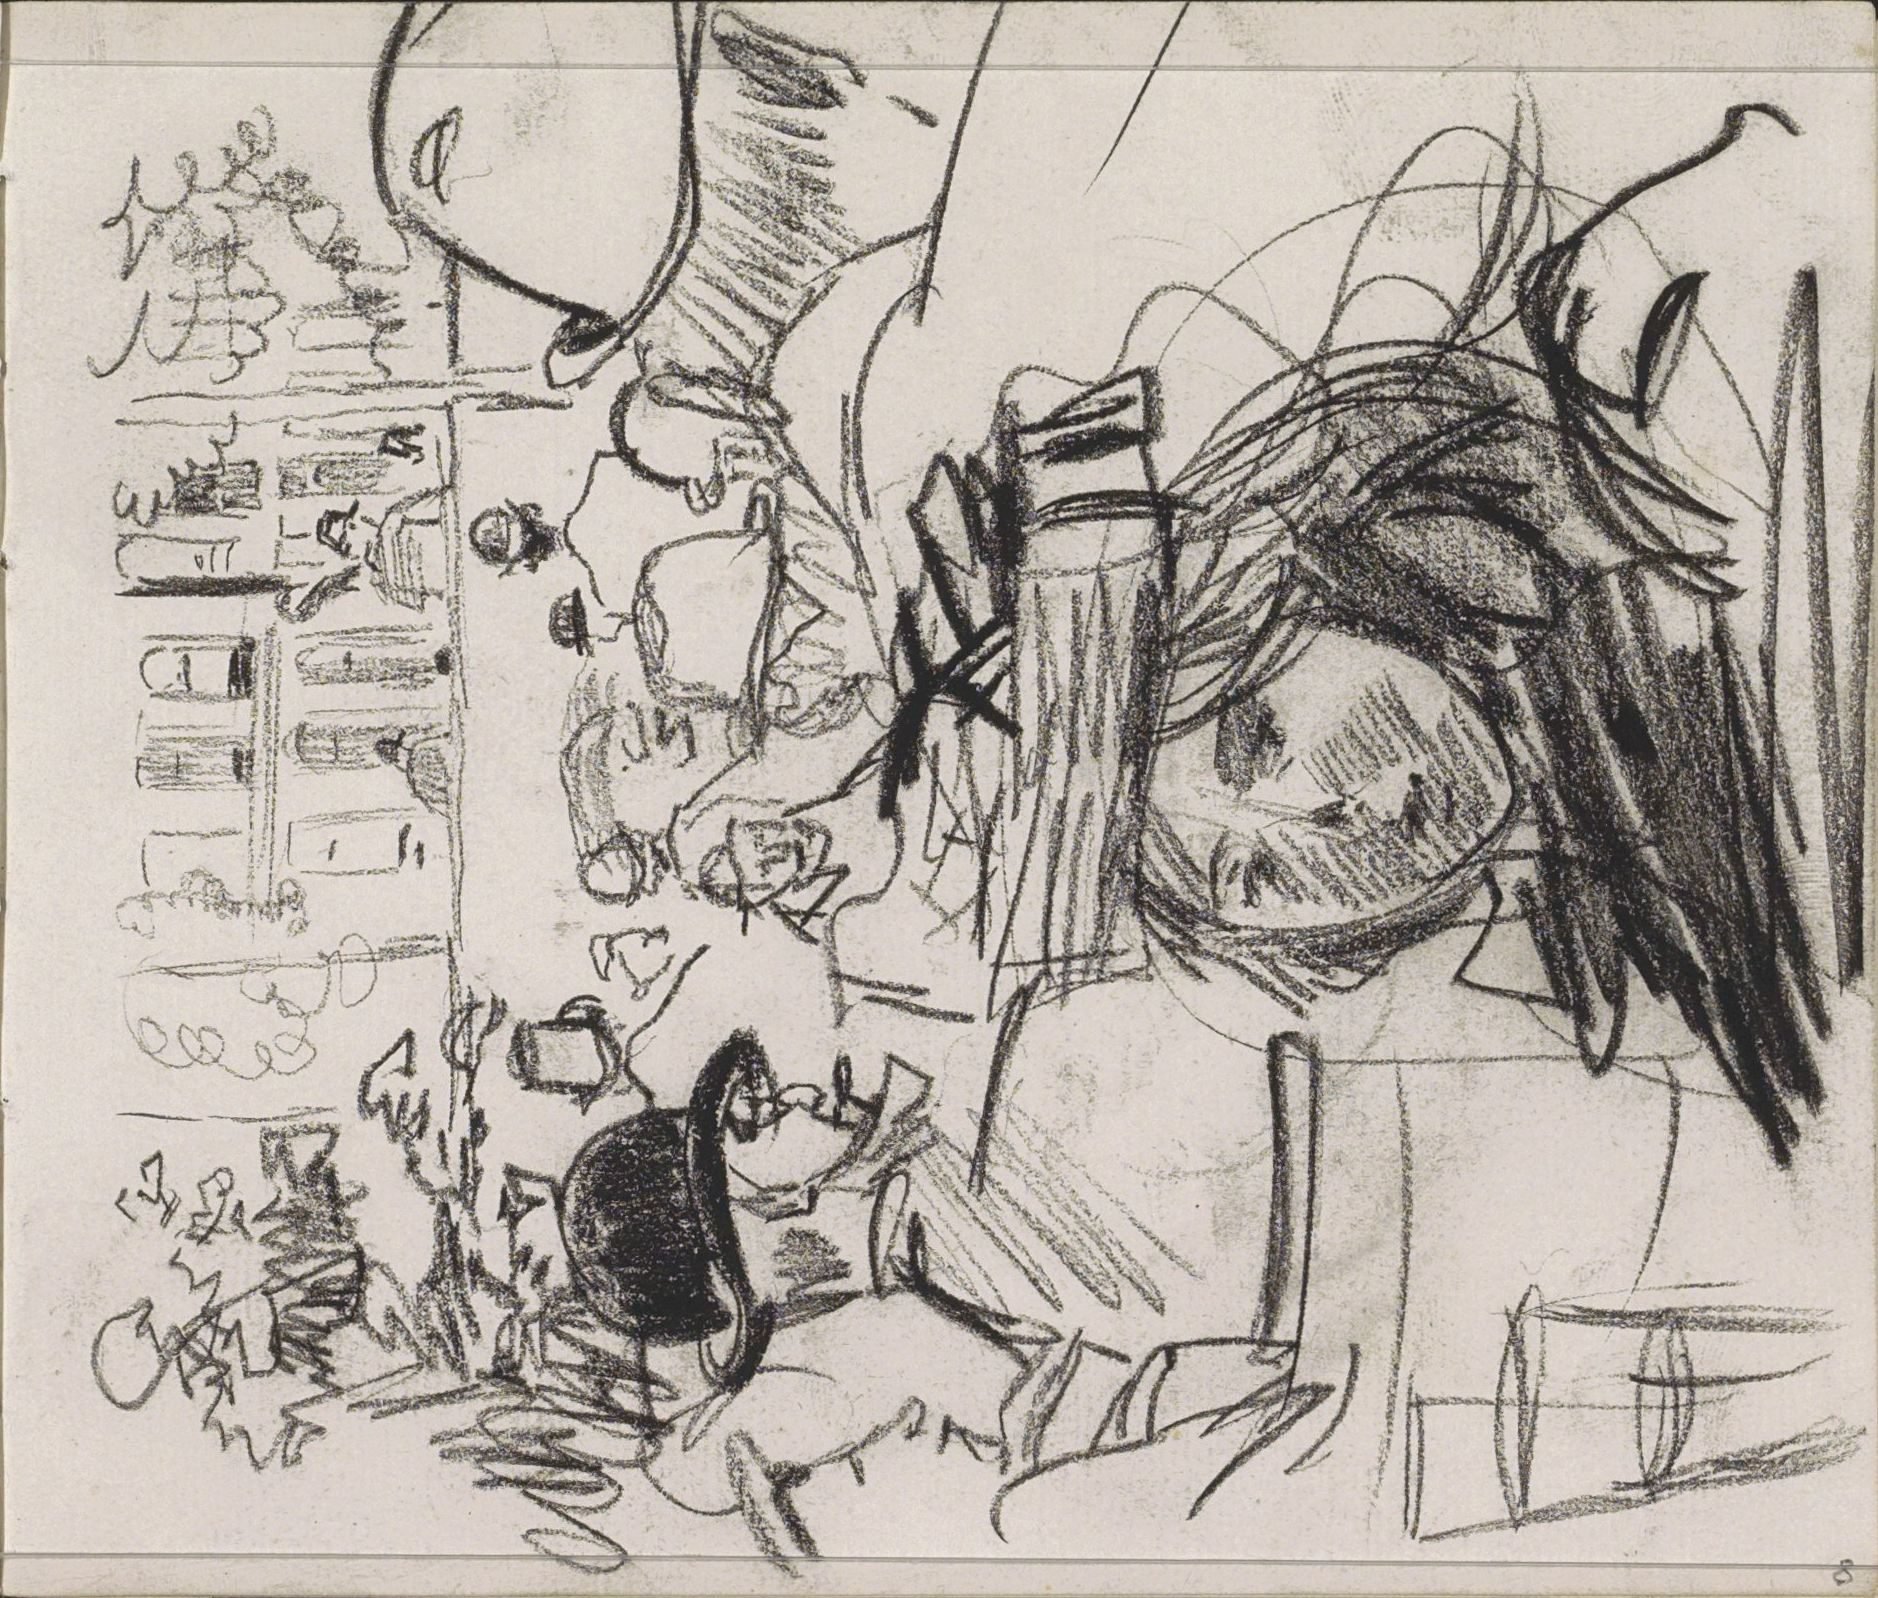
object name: sketchbook leaf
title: Figuren op een terras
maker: isaac israels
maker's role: draughtsman, painter, print maker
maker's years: 1865-1934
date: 1886-1934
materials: chalk, paper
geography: amsterdam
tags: girl (child between toddler and youth), pavement, terrace in front of inn or restaurant, civic architecture; edifices; dwellings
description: Vooraan een meisje met hoed. Op de achtergrond een gebouw. Blad 8 recto uit schetsboek LIV met 18 bladen.